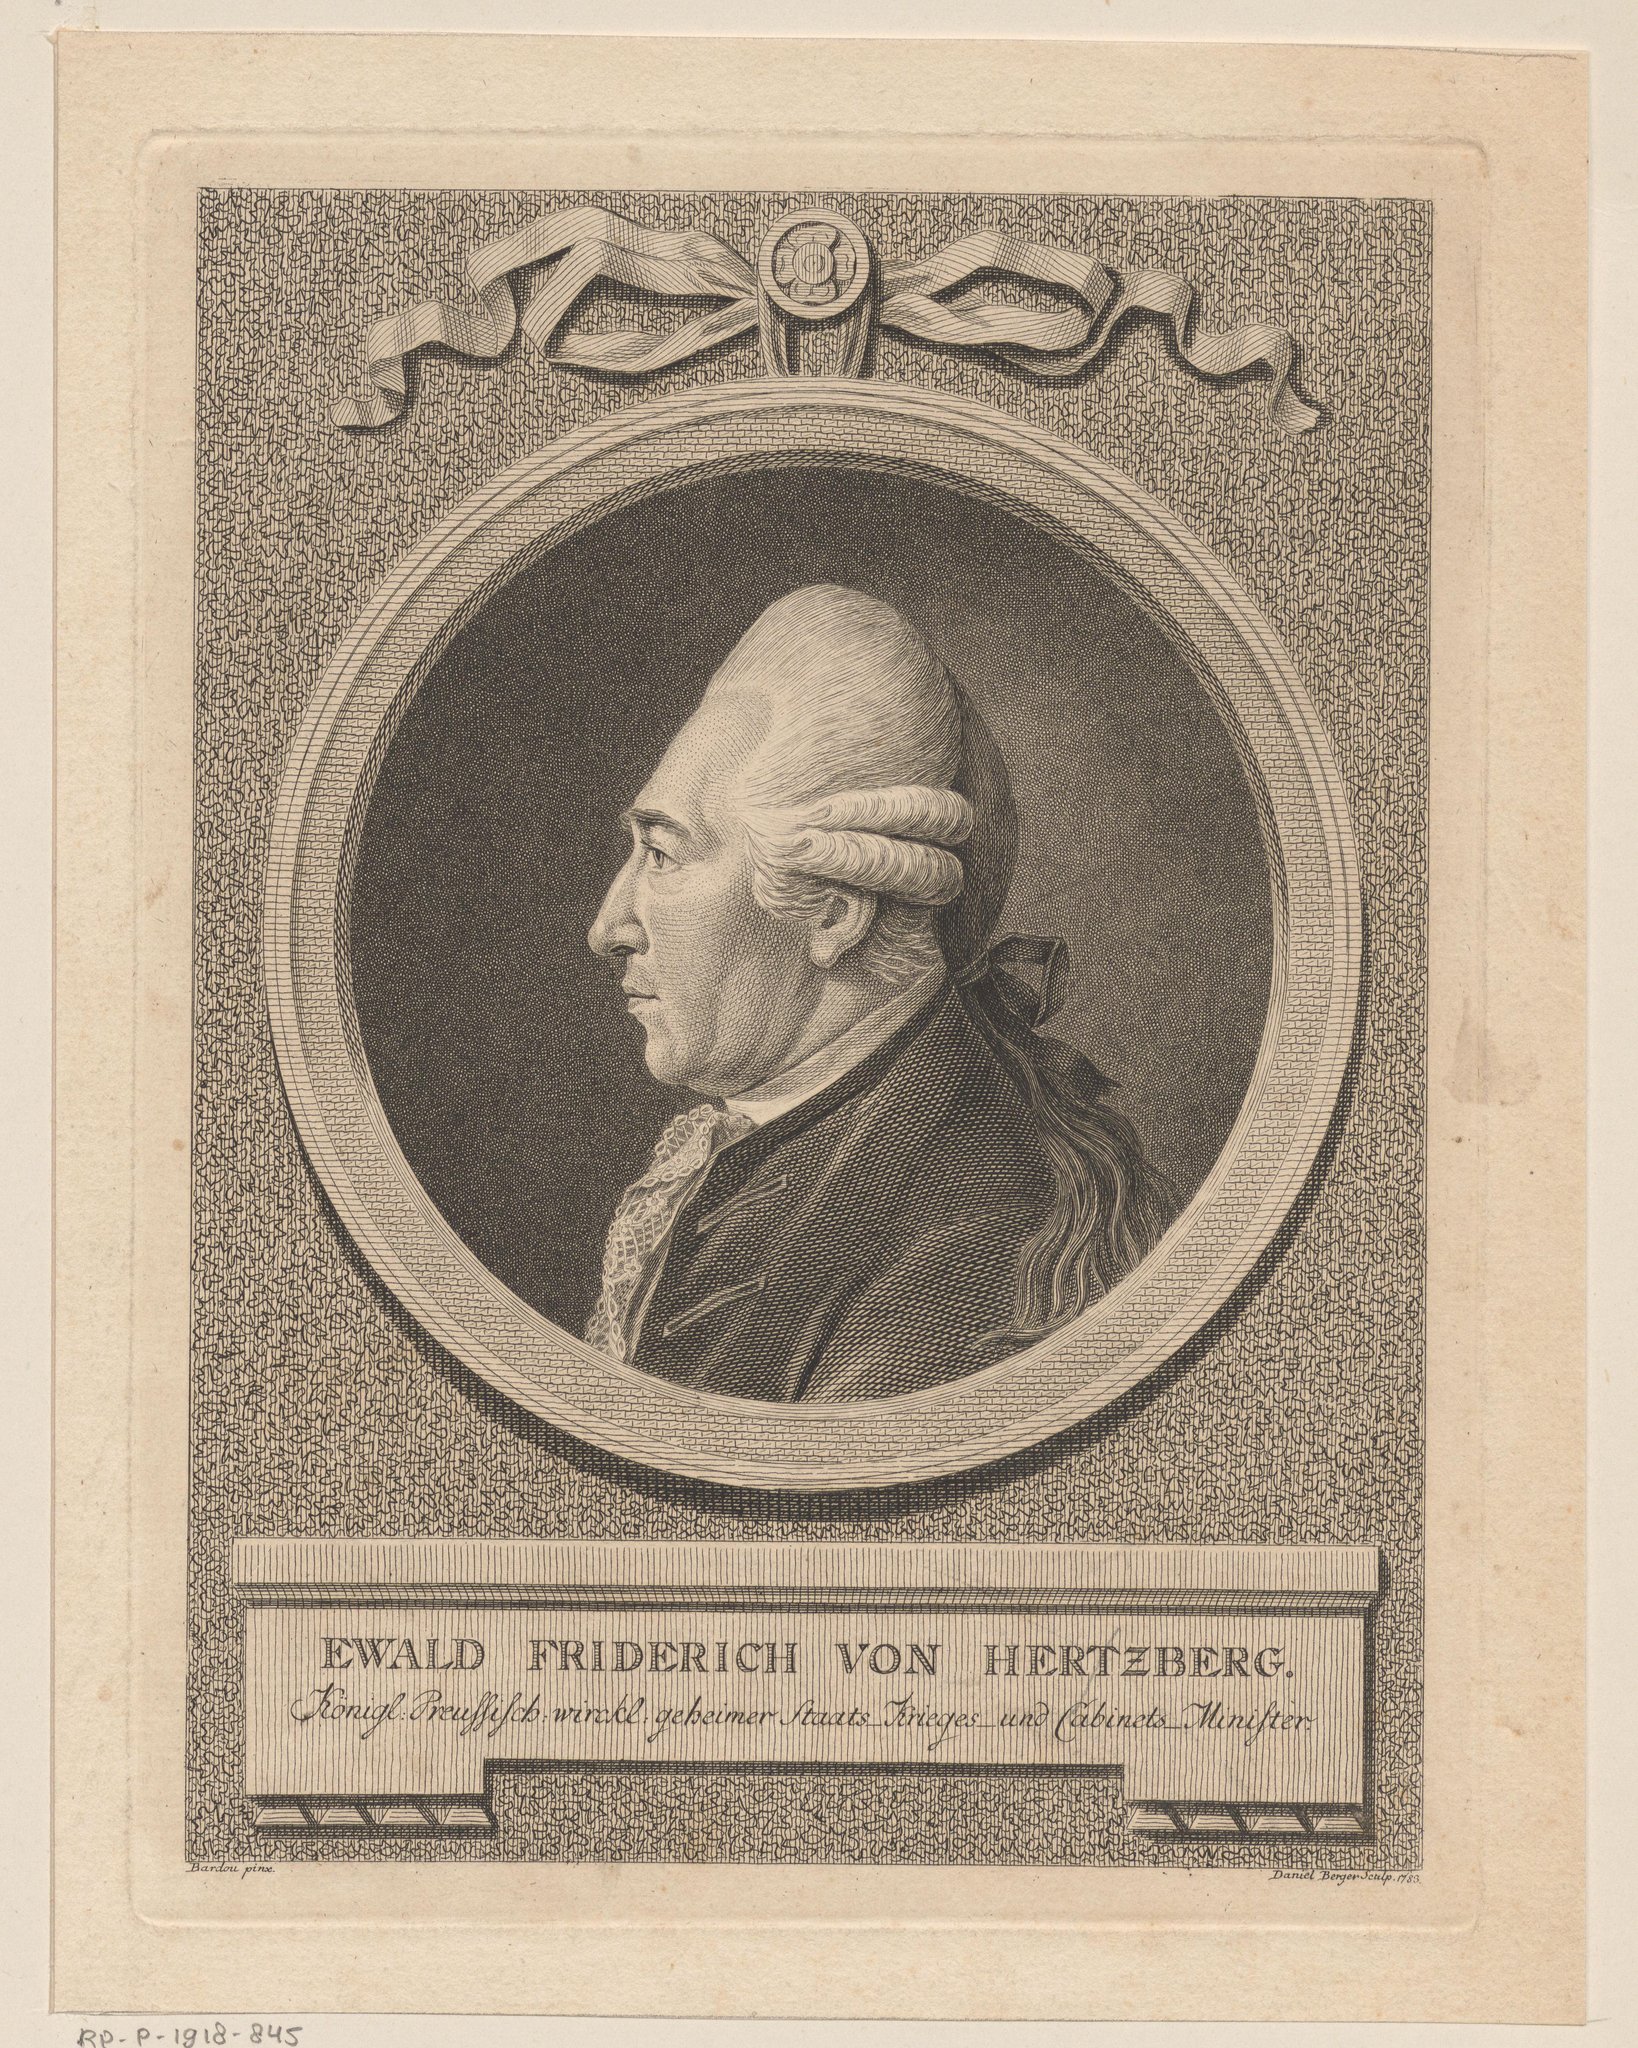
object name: print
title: Portret van Ewald Friedrich von Hertzberg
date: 1783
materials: paper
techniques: engraving, etching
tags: poland, berlin, ewald friedrich von hertzberg (graaf), historical persons, politician, e.g. party leader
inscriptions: collector's mark: Lugt 2233